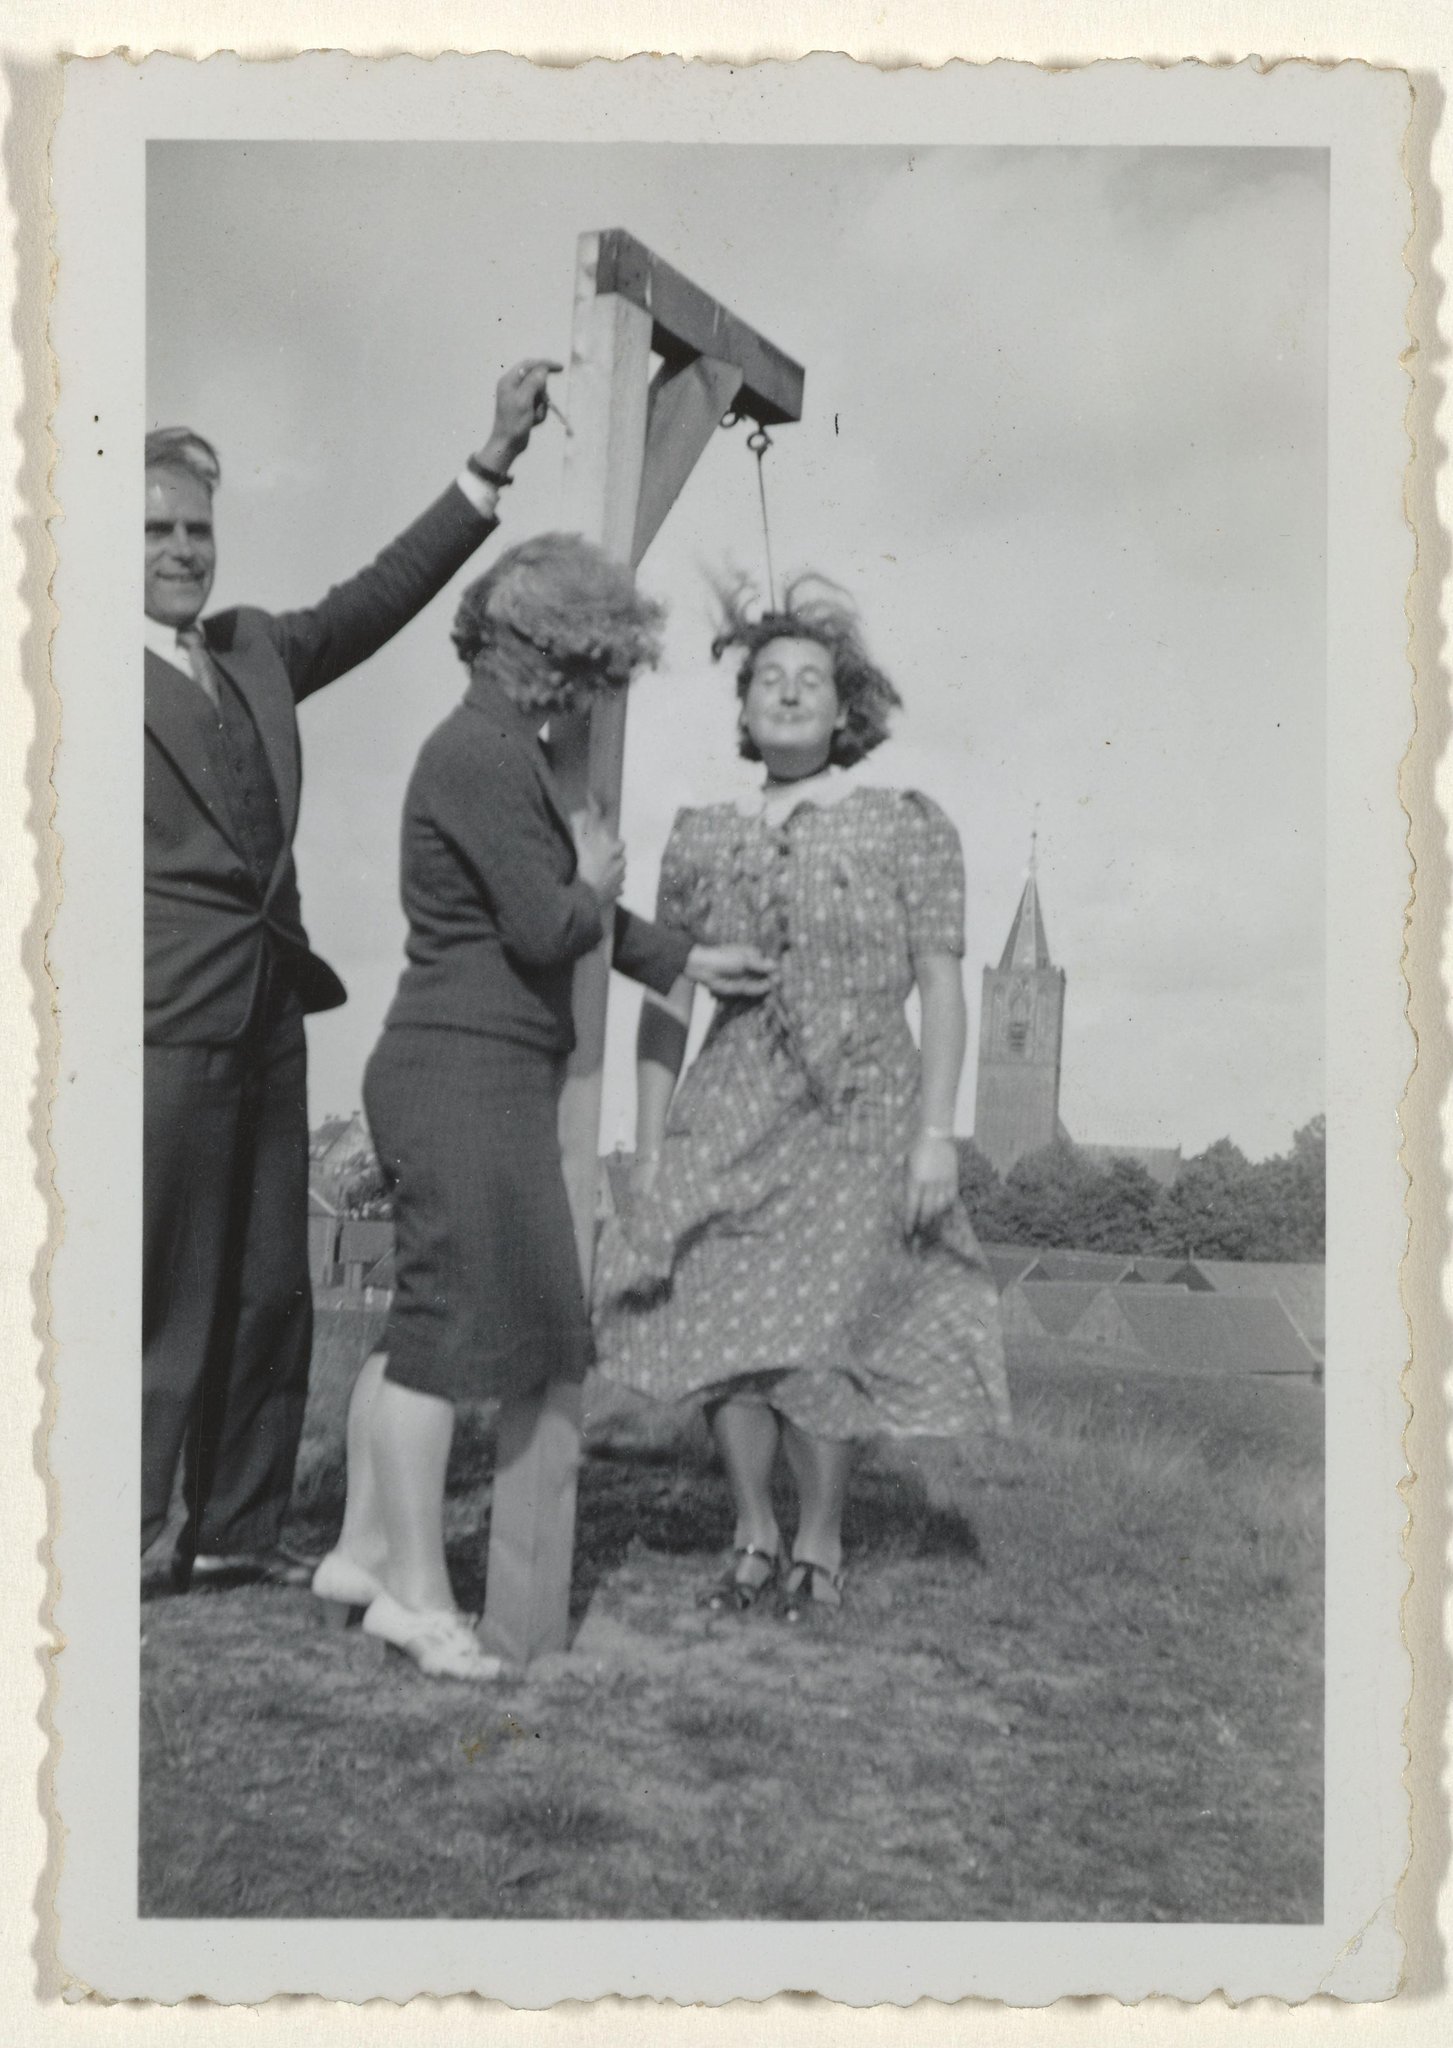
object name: photograph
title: Man en vrouw hangen een vrouw op aan een nepgalg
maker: Anonymous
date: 1925-1950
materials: paper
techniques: gelatin silver print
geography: naarden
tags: instruments of torture, execution or punishment: gallows, adult man, adult woman (+ two persons), parts of church exterior and annexes: tower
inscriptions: inscription: ‘AO’, number: ‘2127’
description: Portret van een man en een vrouw die een andere vrouw ophangen aan een nepgalg. Op de achtergrond is de kerktoren van Naarden te zien.